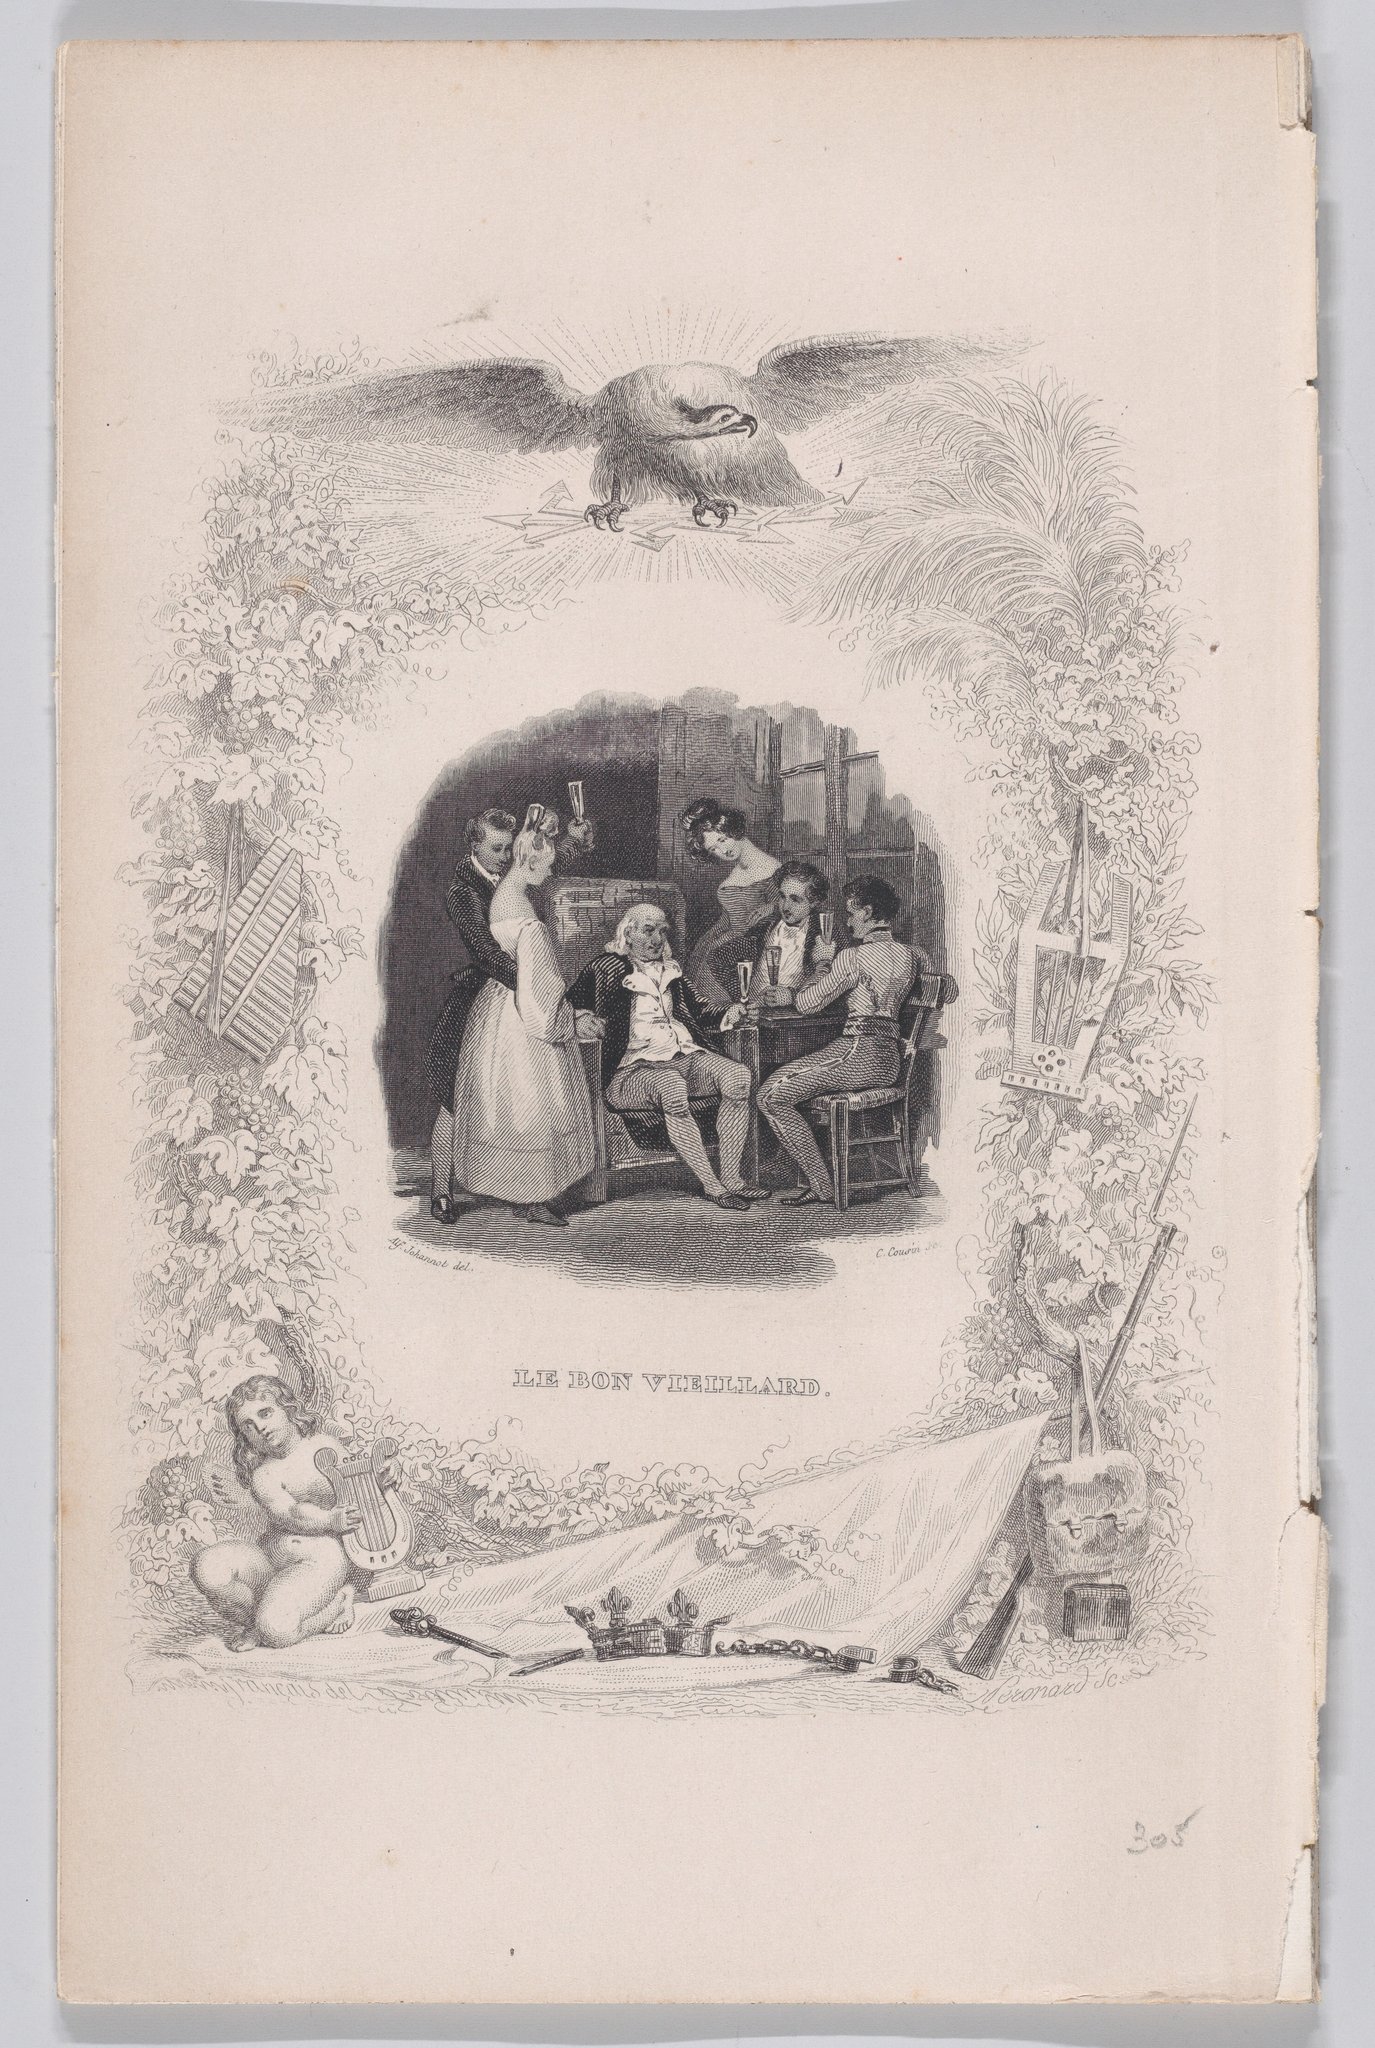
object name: print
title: The Good Old Man, from "The Complete Works of Béranger"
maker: alfred johannot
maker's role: designer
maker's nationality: french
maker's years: 1800-1837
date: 1829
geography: paris